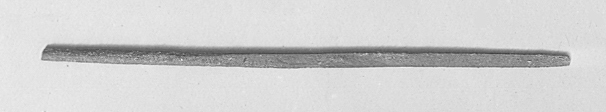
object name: chisel or awl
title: Chisel or Awl From Foundation Deposit 2 of Hatshepsut's Valley Temple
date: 1479-1458 BCE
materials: bronze, copper alloy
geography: egypt